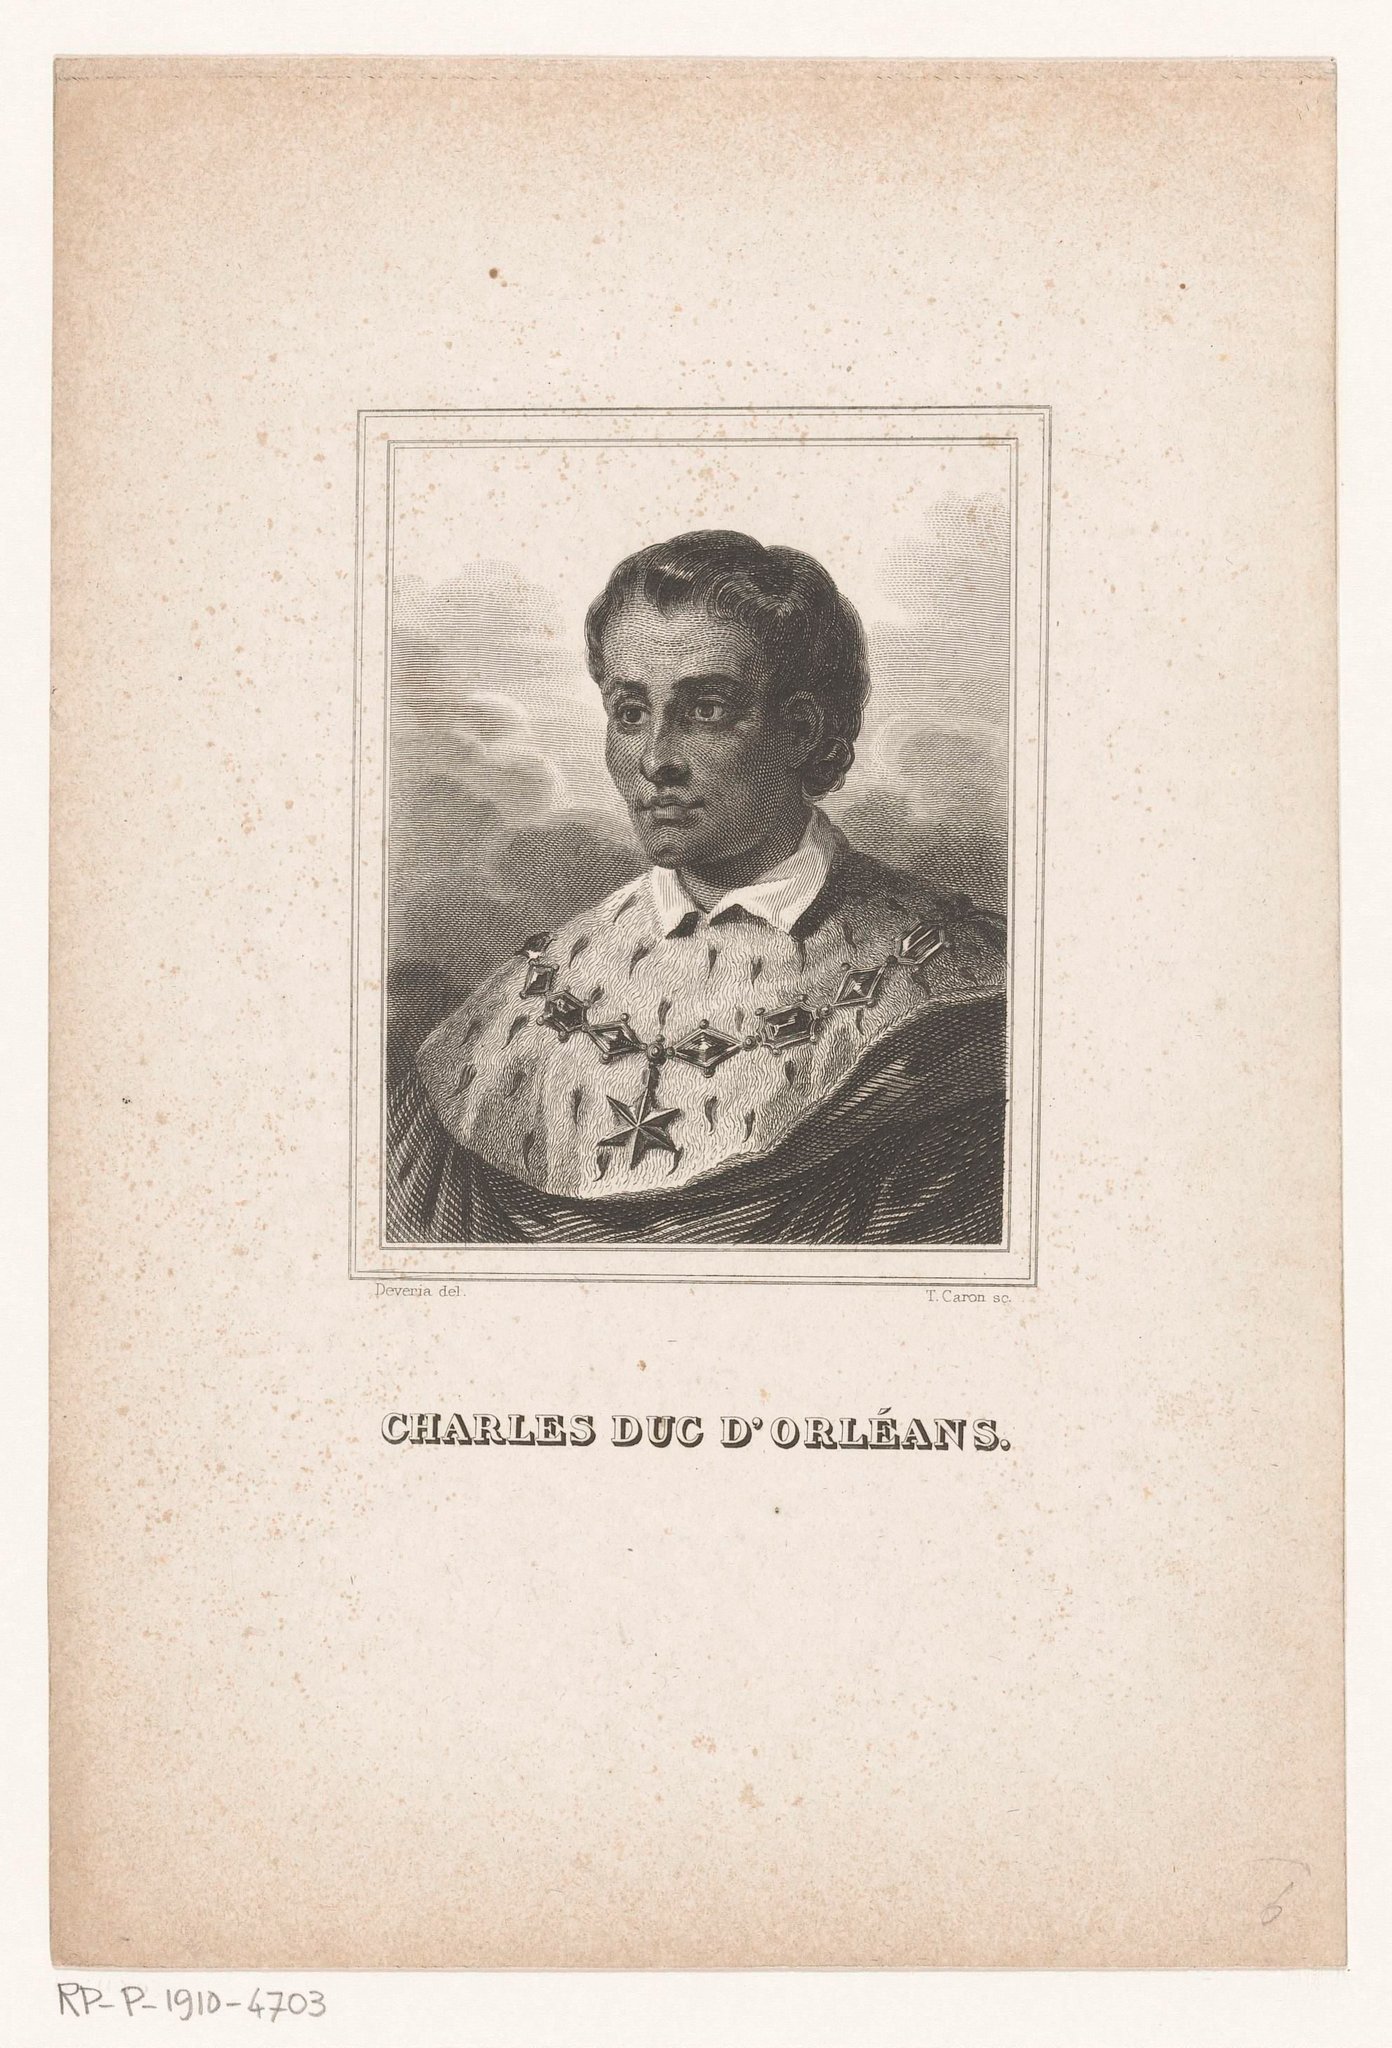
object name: print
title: Charles duc d'Orléans.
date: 1800-1832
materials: paper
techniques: engraving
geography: france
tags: historical persons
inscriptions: collector's mark: Lugt 2228